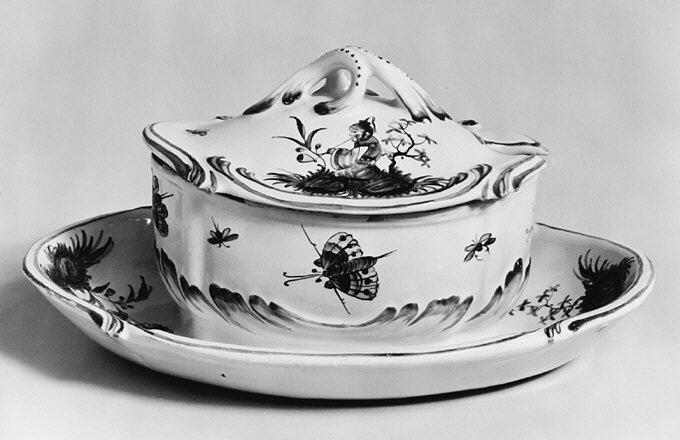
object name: tureen with cover and stand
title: Tureen with covered stand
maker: charles loyal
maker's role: factory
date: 1780-1785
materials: faience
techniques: glazing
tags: chinoiserie,women,insects,butterflies